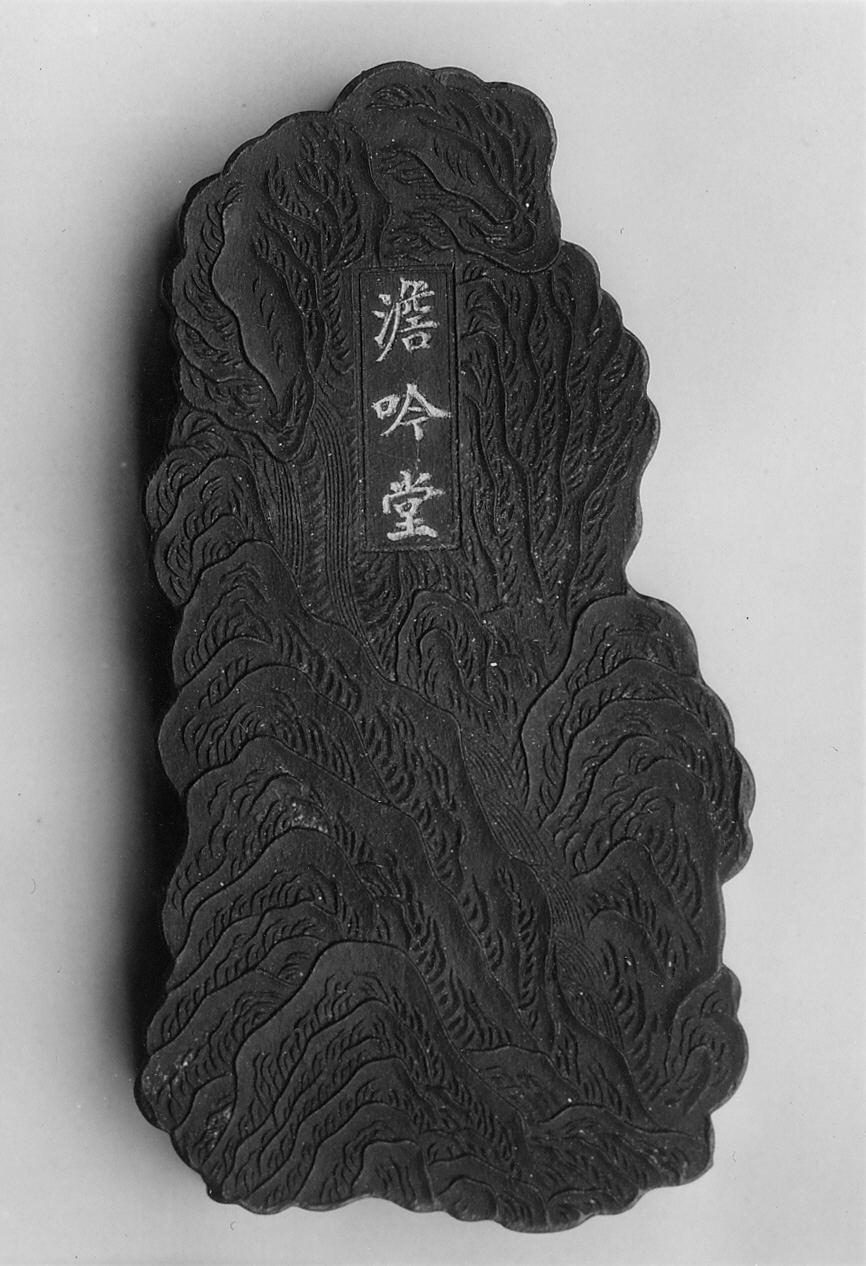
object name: ink tablet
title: Hall for Serene Chanting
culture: chinese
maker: jian guzhai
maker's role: artist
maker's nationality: chinese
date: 1867-1933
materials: gilt, wood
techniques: bookbinding